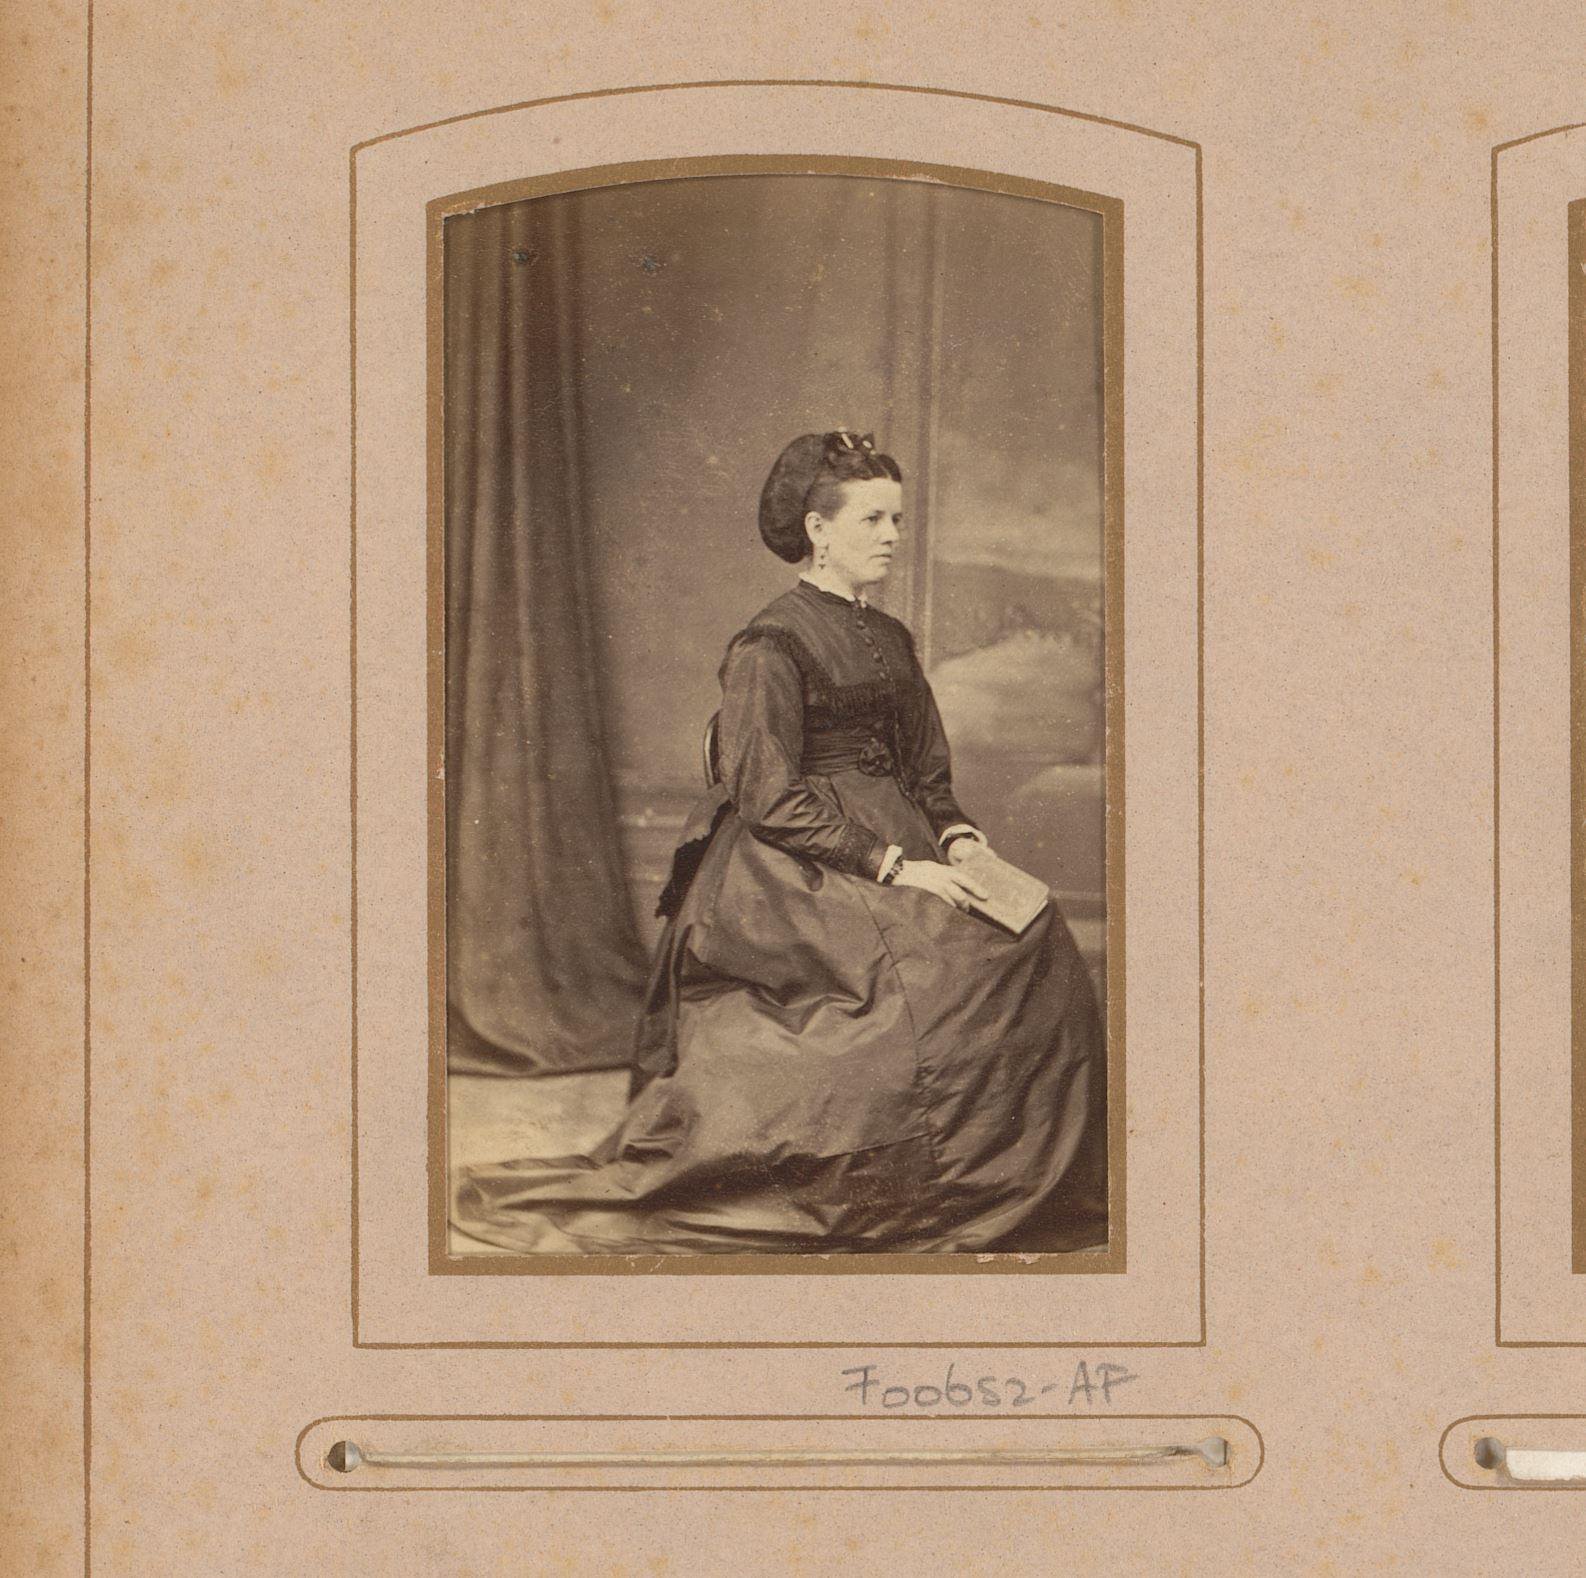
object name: photograph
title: Portret van een vrouw met boek in de hand, zittend op een stoel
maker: robert hellis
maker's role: fotograaf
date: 1860-1880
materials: cardboard, photographic support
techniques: albumen print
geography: london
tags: sitting figure - aa - female human figure, historical persons - bb - woman, book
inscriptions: inscription: ‘ROBERT HELLIS/ PHOTOGRAPHER/ 10 The Terrace Kensington/ ANDAT/ 13, Silver Str/ NOTTINGHILL/ LONDON W./ Copies may be had’